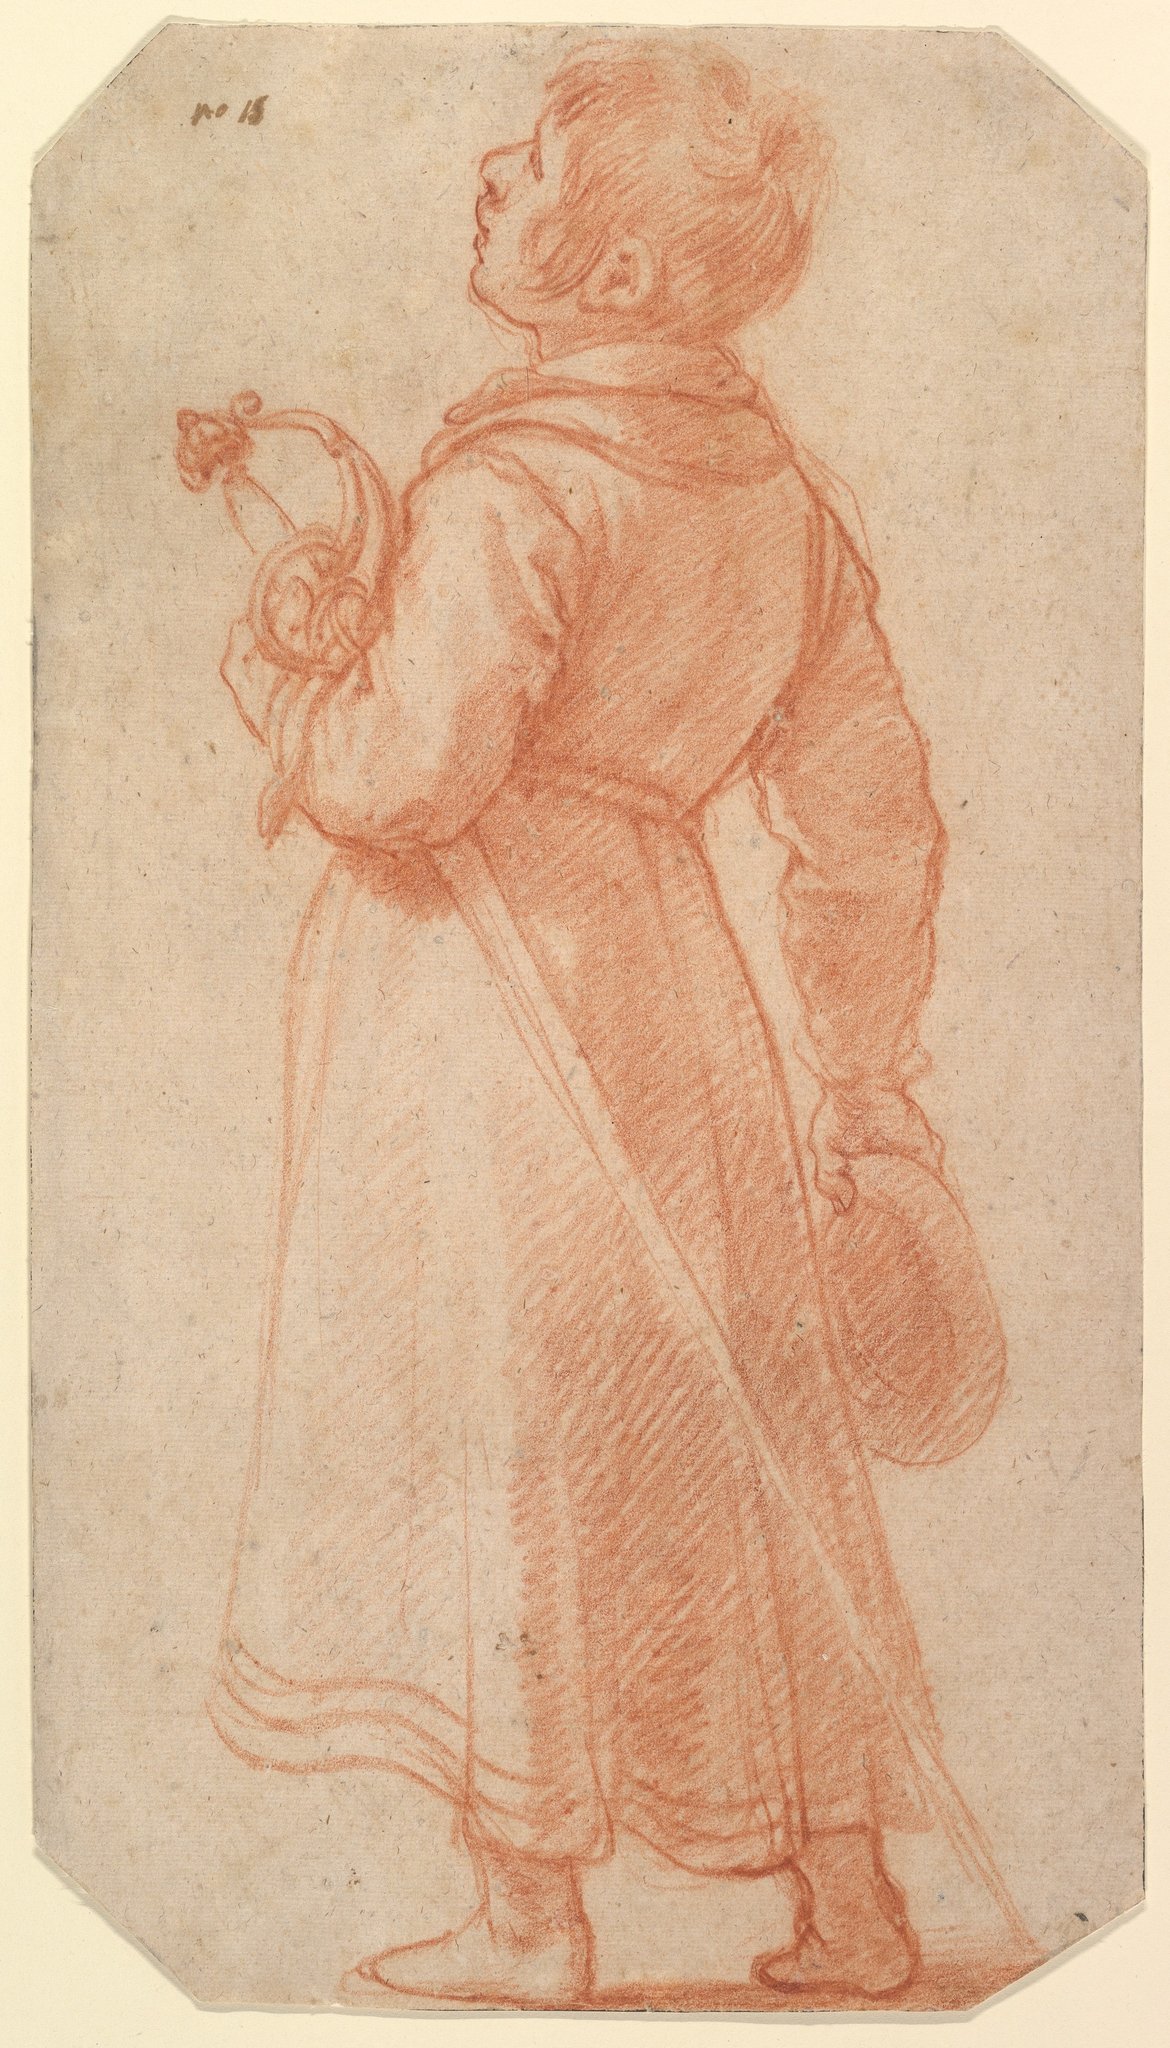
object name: drawing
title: A Young Boy Seen from Behind, holding a sword and cap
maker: matteo rosselli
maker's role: artist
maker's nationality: italian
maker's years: 1578-1650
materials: chalk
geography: italy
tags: hats,swords,boys